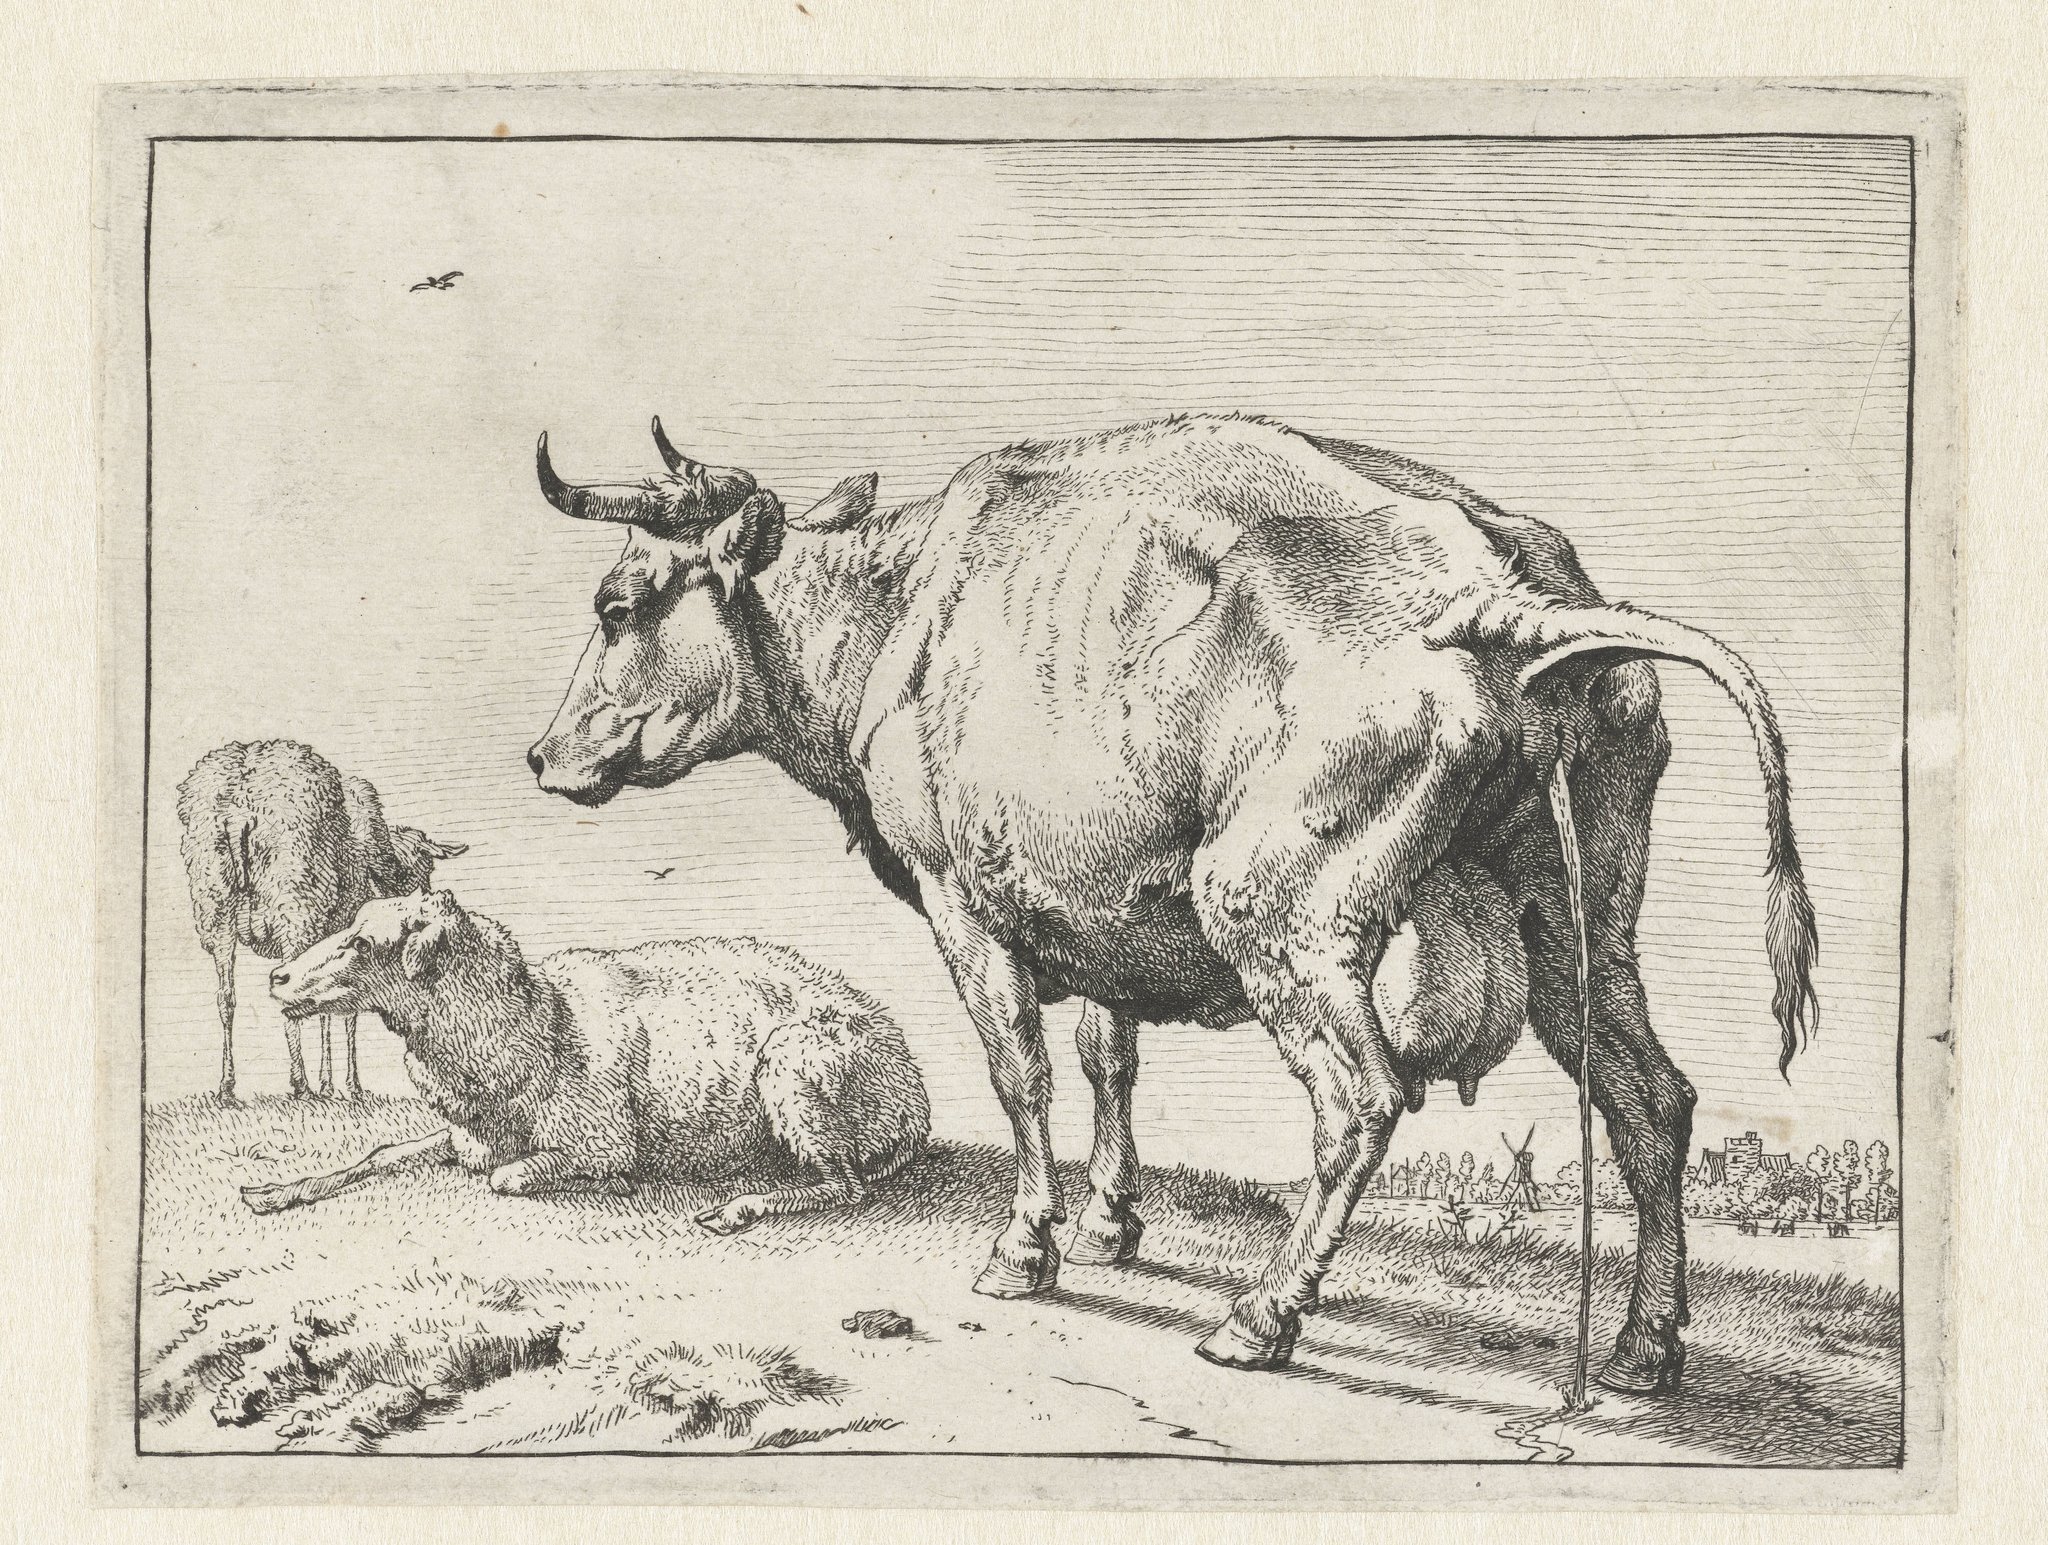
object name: print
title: Het Bullenboekje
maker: paulus potter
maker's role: draughtsman, painter, print maker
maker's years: 1625-1654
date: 1650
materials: paper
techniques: etching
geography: netherlands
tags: cow, urination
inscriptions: collector's mark: Lugt 240